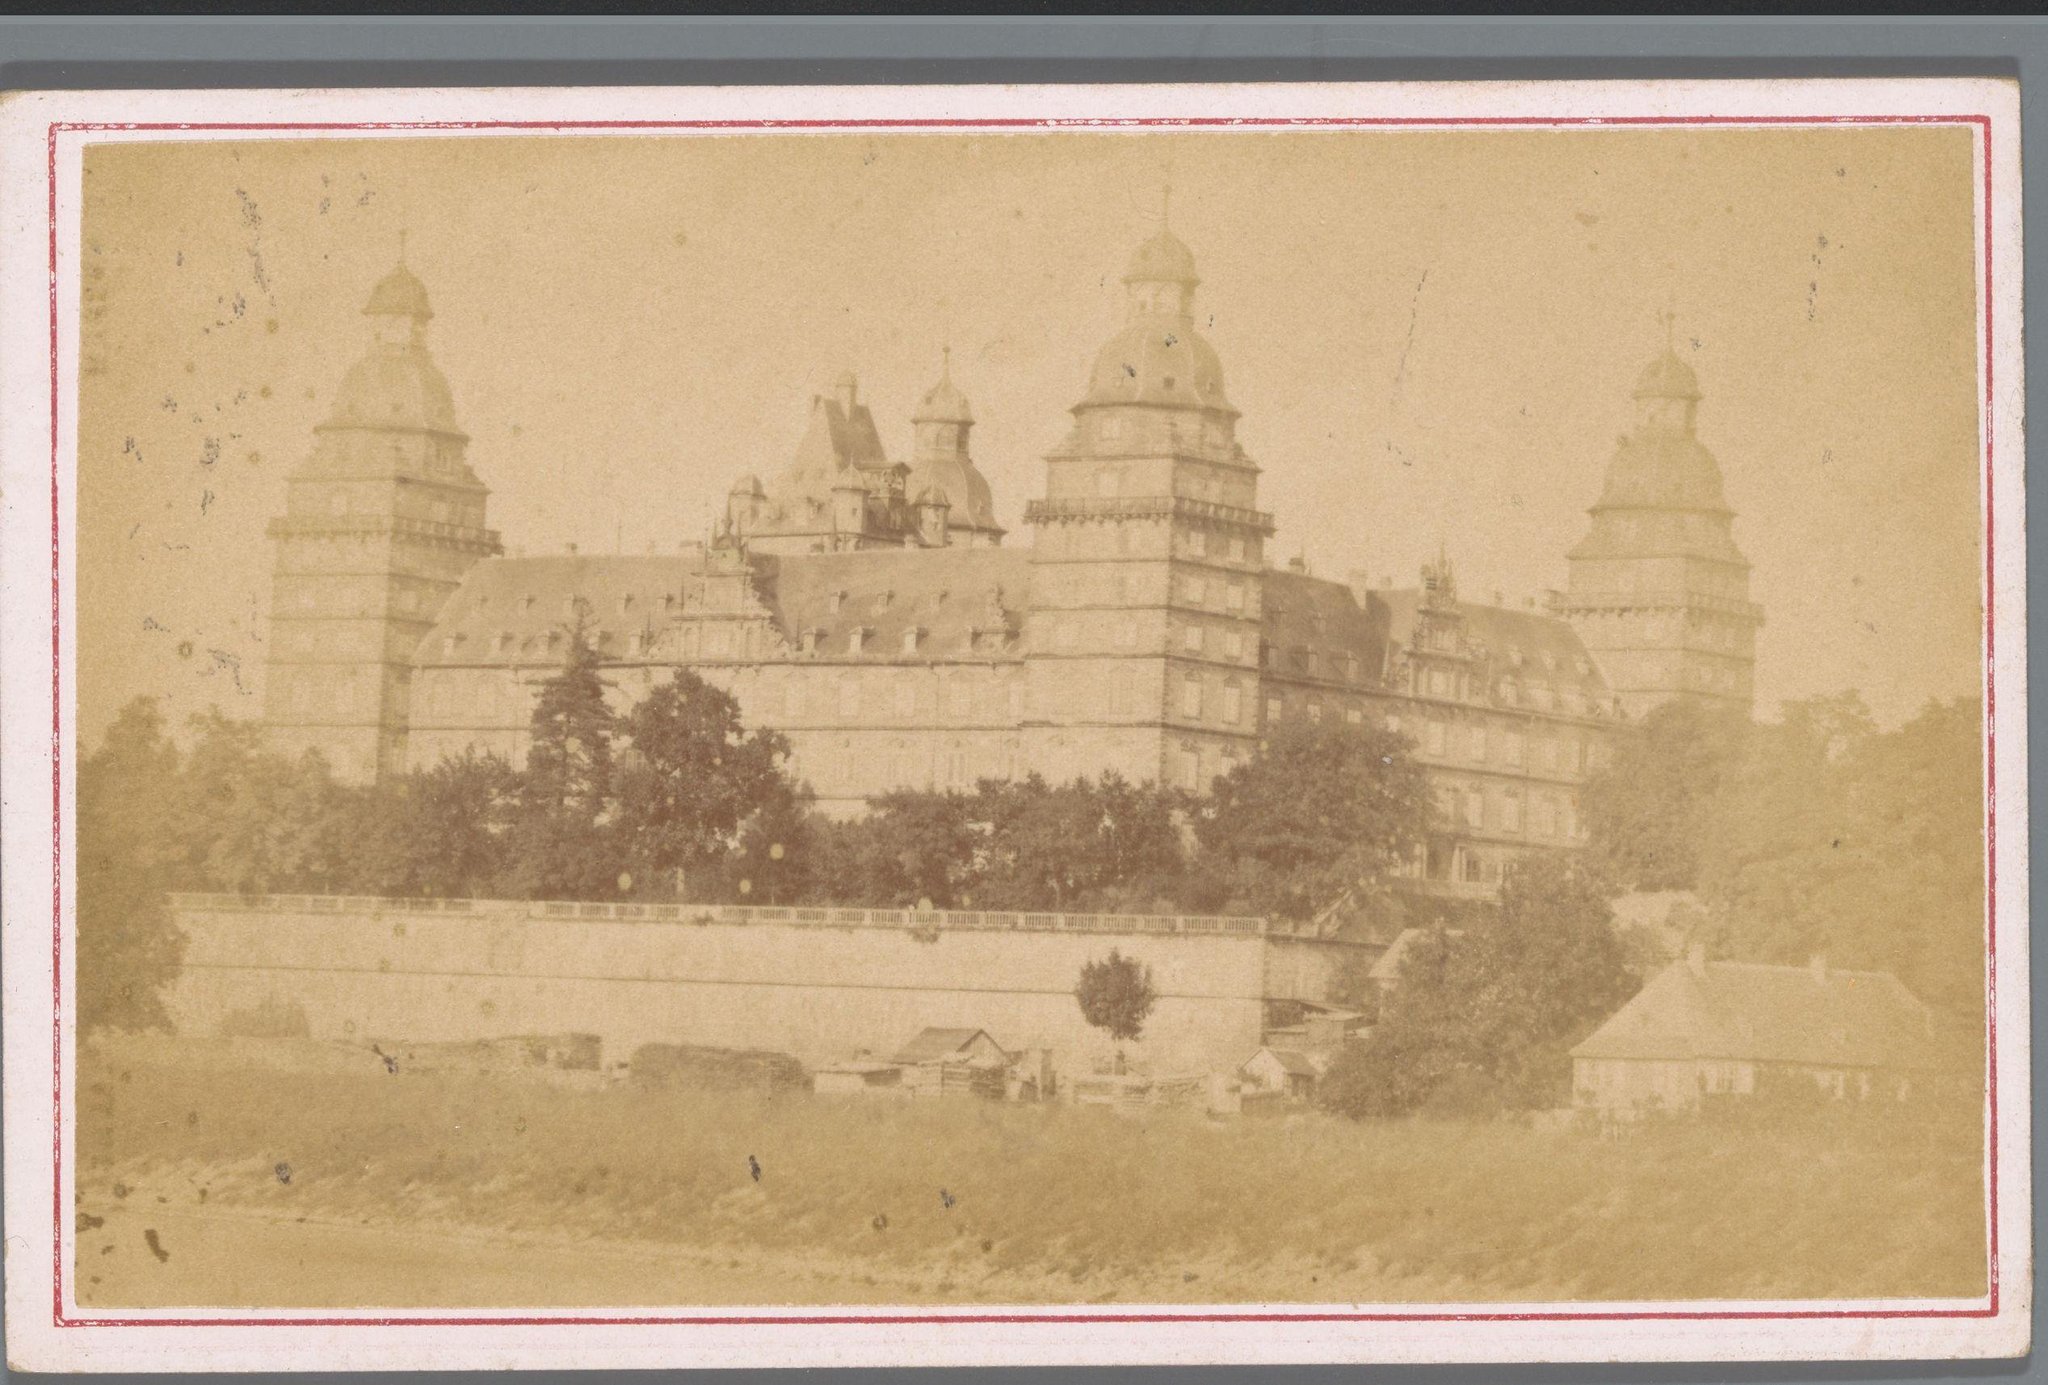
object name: carte de visite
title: Slot Johannisburg in Aschaffenburg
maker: m. wacker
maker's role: fotograaf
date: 1855-1885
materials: cardboard, paper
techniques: albumen print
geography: aschaffenburg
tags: castle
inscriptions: inscription: ‘Für Nachbestellungen bleibt die Platte aufbewahrt.’, inscription: ‘M. Wacker/ Photograph/ Aschaffenburg/ Weissenburger-u. Frohsinn-Str.’, monogram: ‘MW’